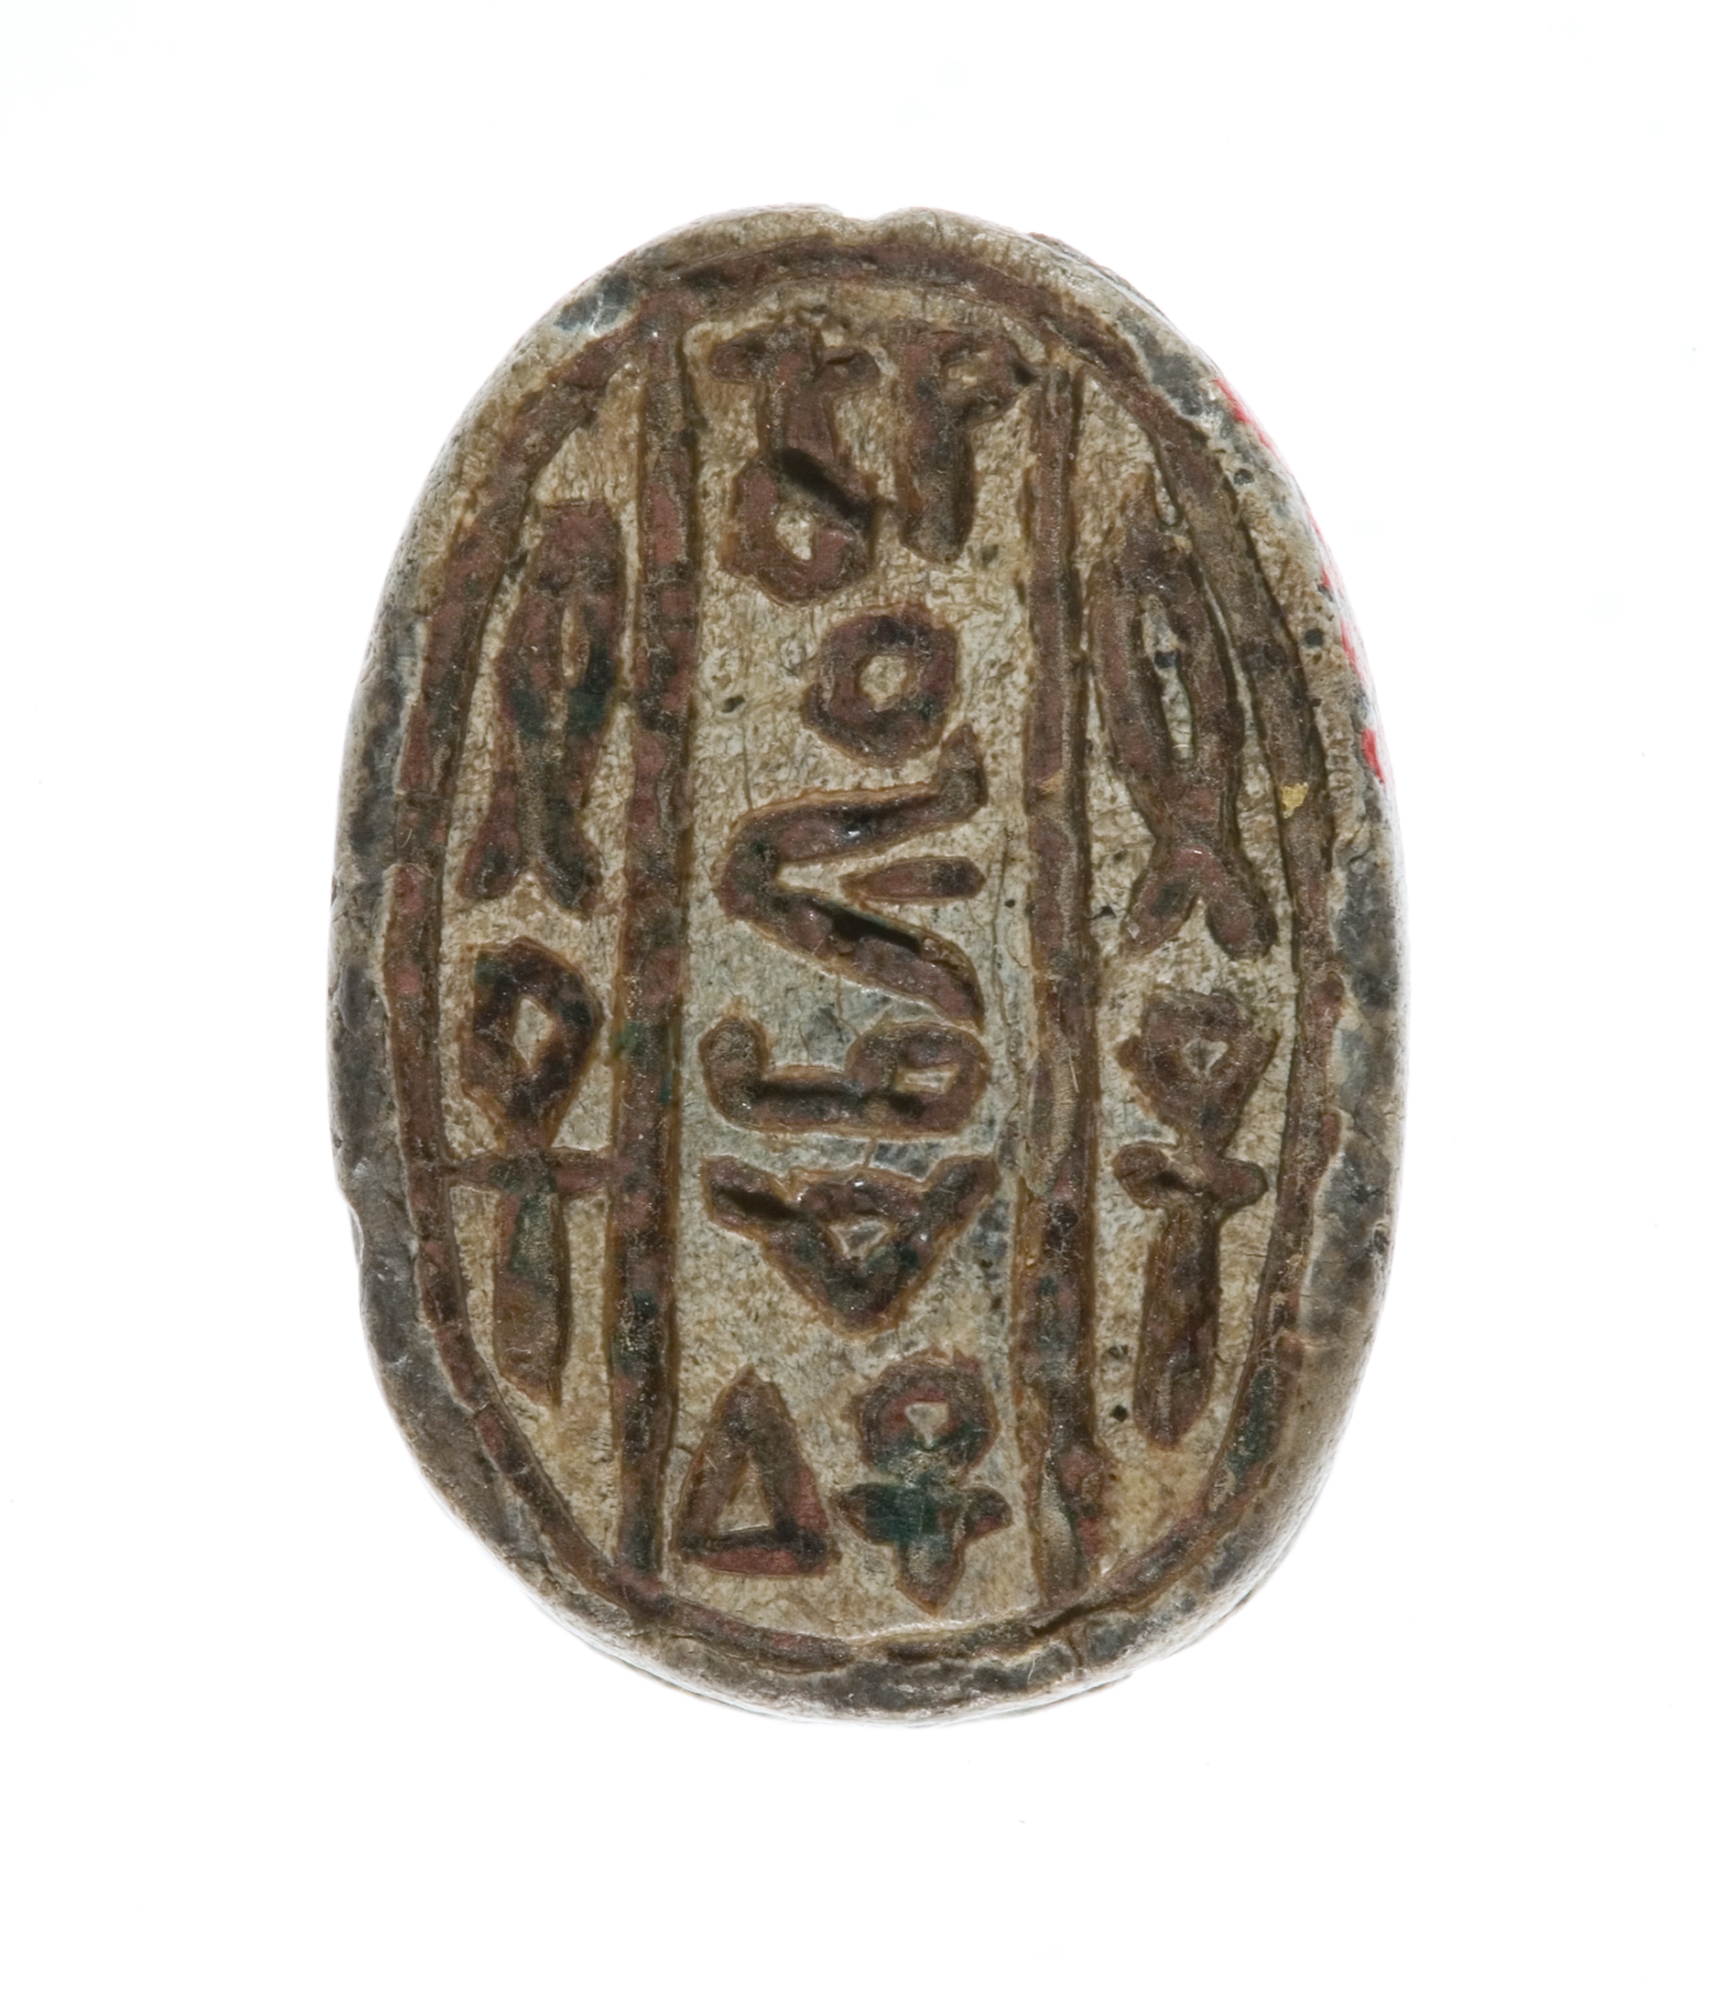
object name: scarab, king sheshi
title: Scarab with the Name of the Hyksos King Sheshi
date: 1700 BCE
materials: stone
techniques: glazing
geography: egypt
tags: hieroglyphs,scarabs